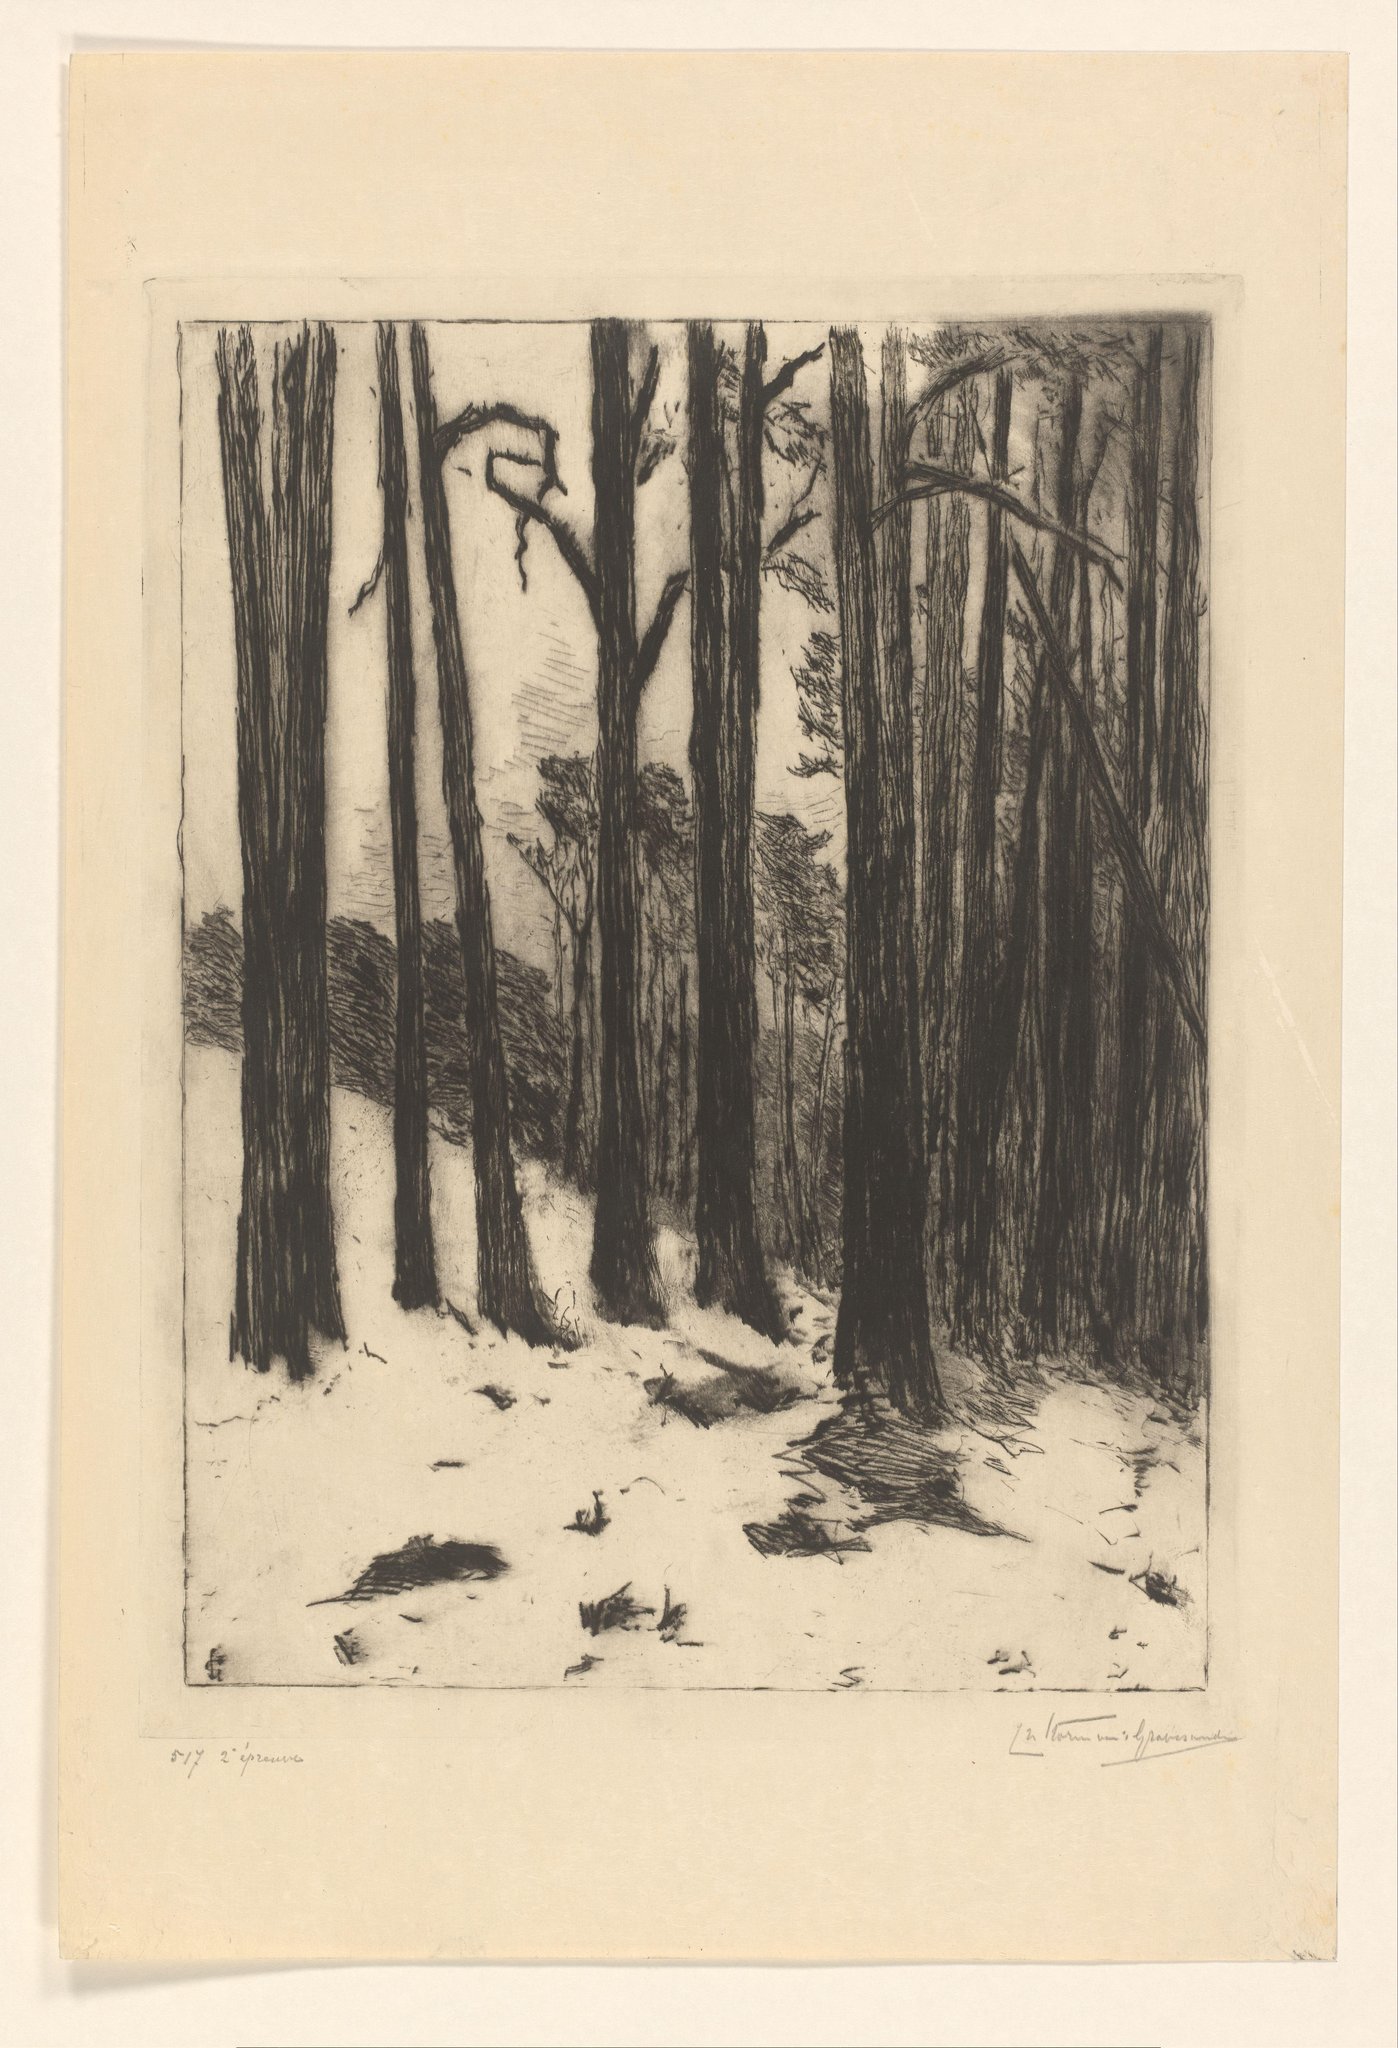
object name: print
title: Bos in de sneeuw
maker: carel nicolaas storm van s-gravesande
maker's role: draughtsman, print maker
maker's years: 1841-1924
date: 1851-1924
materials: paper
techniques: drypoint, intaglio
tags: forest, wood, snow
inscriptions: collector's mark: Lugt 2228